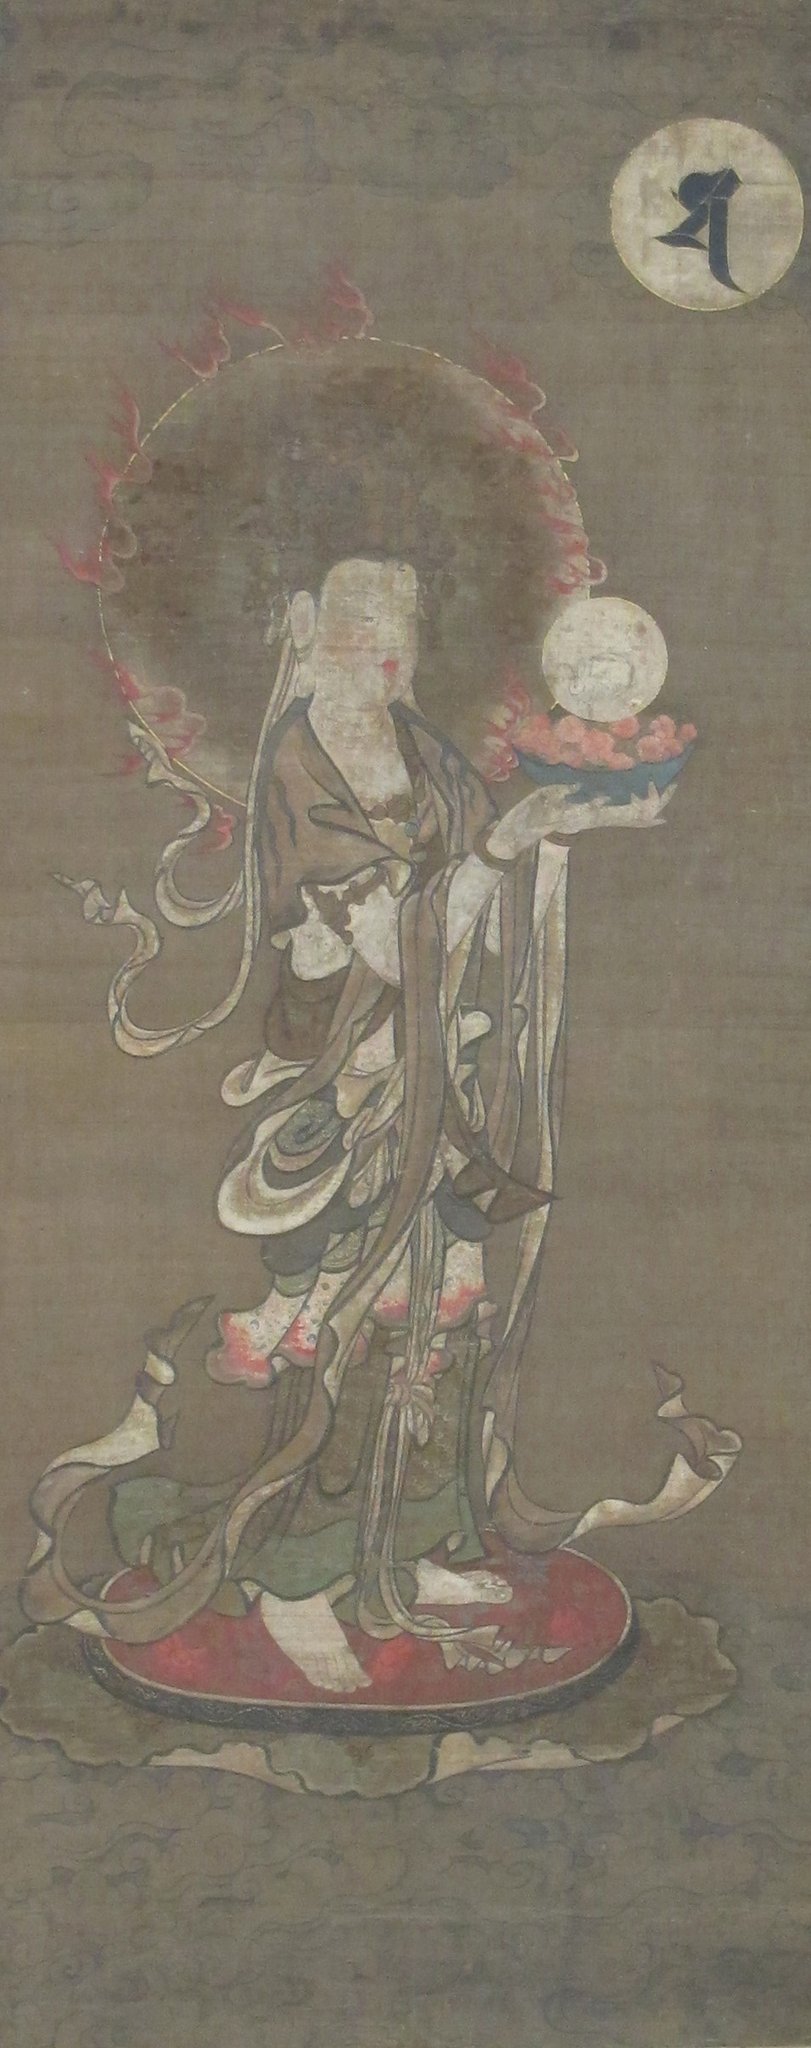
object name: painting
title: One of the Twelve Celestial Guardians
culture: japanese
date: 1351-1400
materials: gold, ink, panel, silk